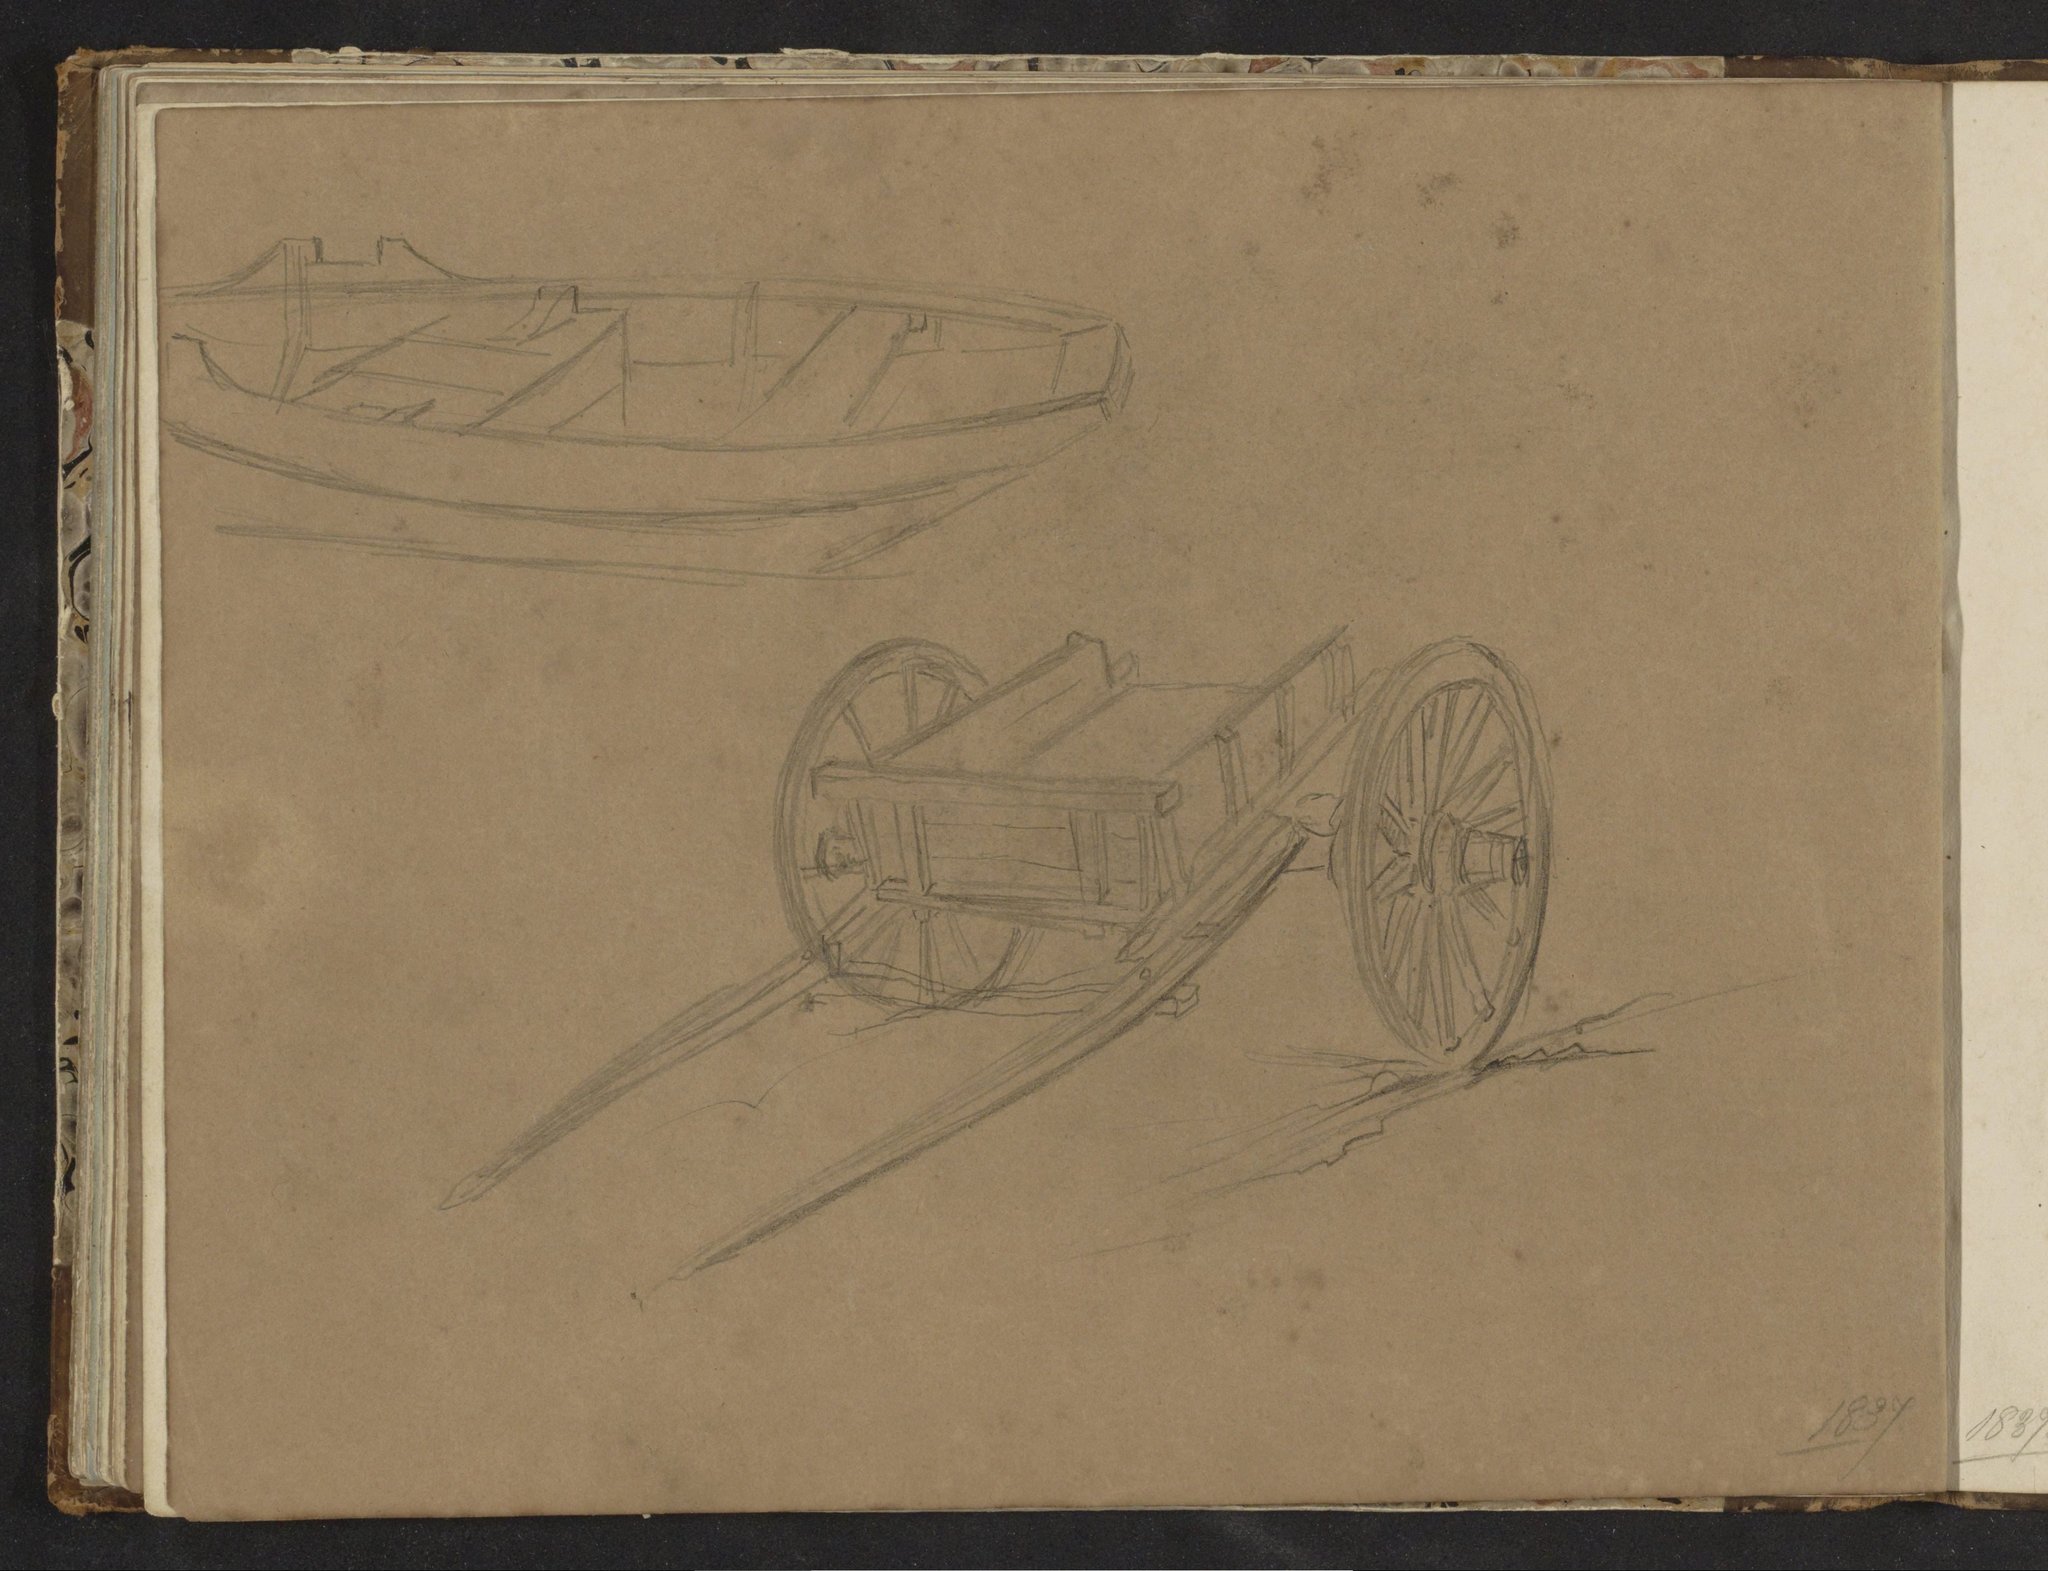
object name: sketchbook leaf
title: Roeiboot en een handkar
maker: johannes tavenraat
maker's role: draughtsman, painter, print maker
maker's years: 1809-1881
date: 1837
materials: paper, pencil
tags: hand-cart, rowing-boat, canoe, etc.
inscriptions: date: ‘1837.’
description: Blad 27 verso uit een schetsboek met 41 bladen.